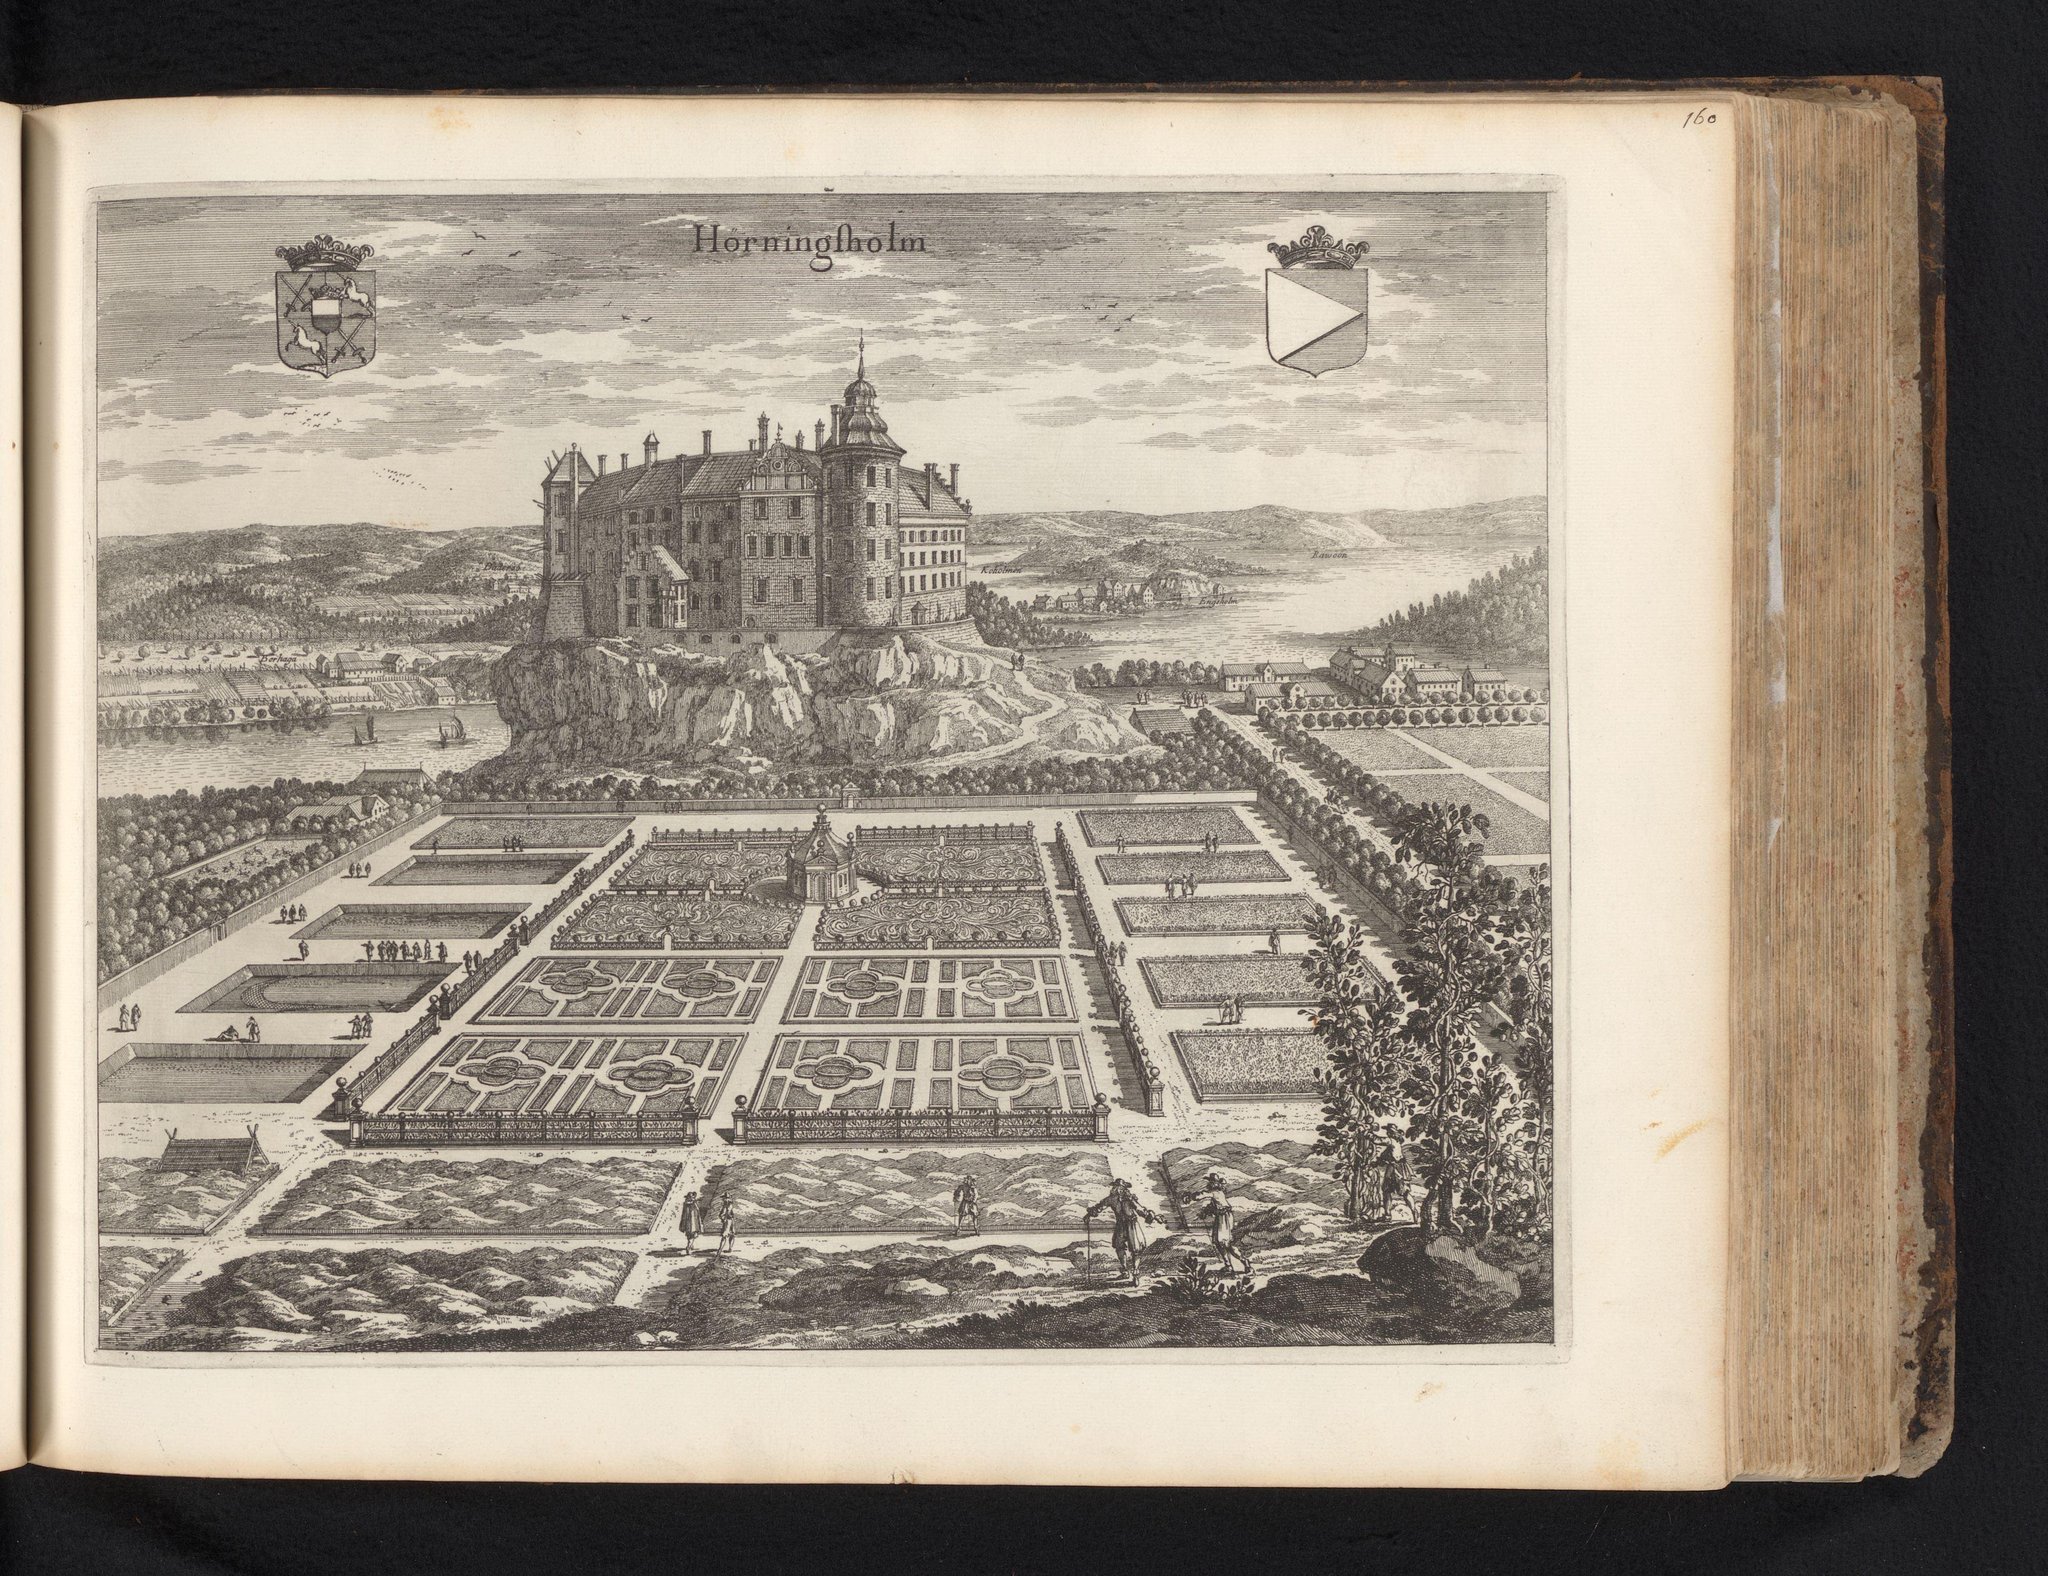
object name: album leaf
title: Gezicht op slot Hörningsholm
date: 1670-1674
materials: paper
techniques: etching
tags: garden, housing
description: Kungliga Biblioteket, 'Suecia': http://www.kb.se/samlingarna/Kartor-bilder/Suecia-antiqua/ (geraadpleegd november 2016).